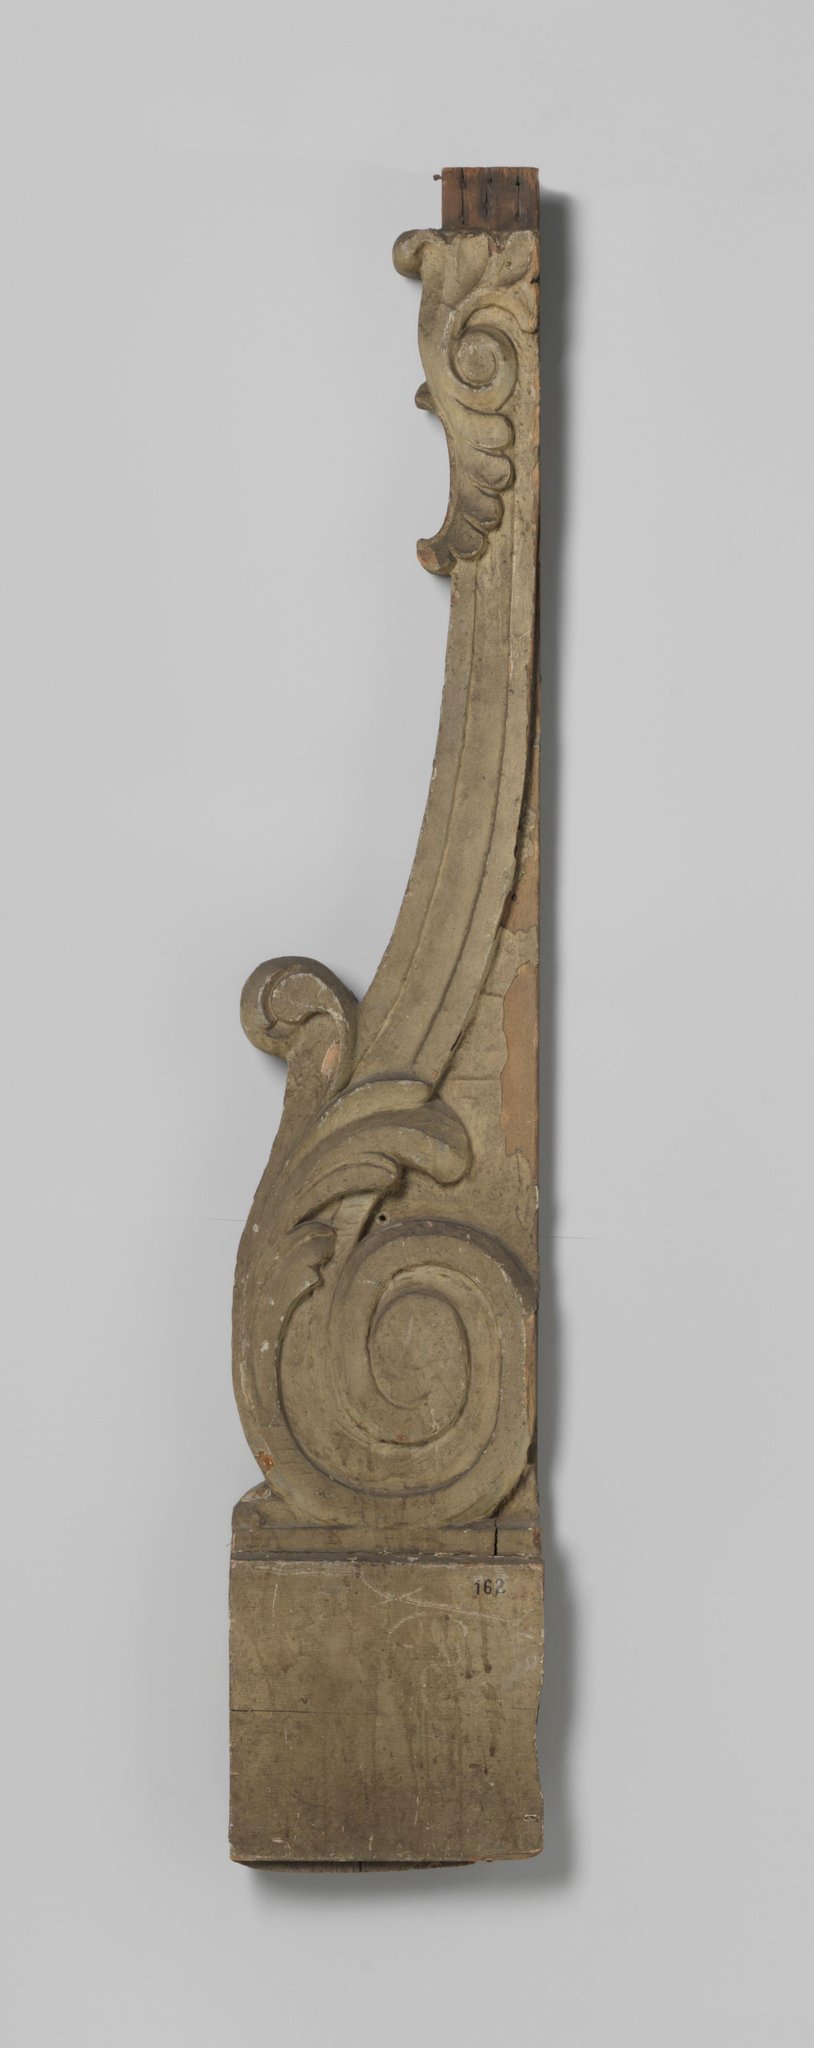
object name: klauwstuk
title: Klauwstuk van een dakkapel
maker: Anonymous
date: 1400-1950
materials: paint, wood